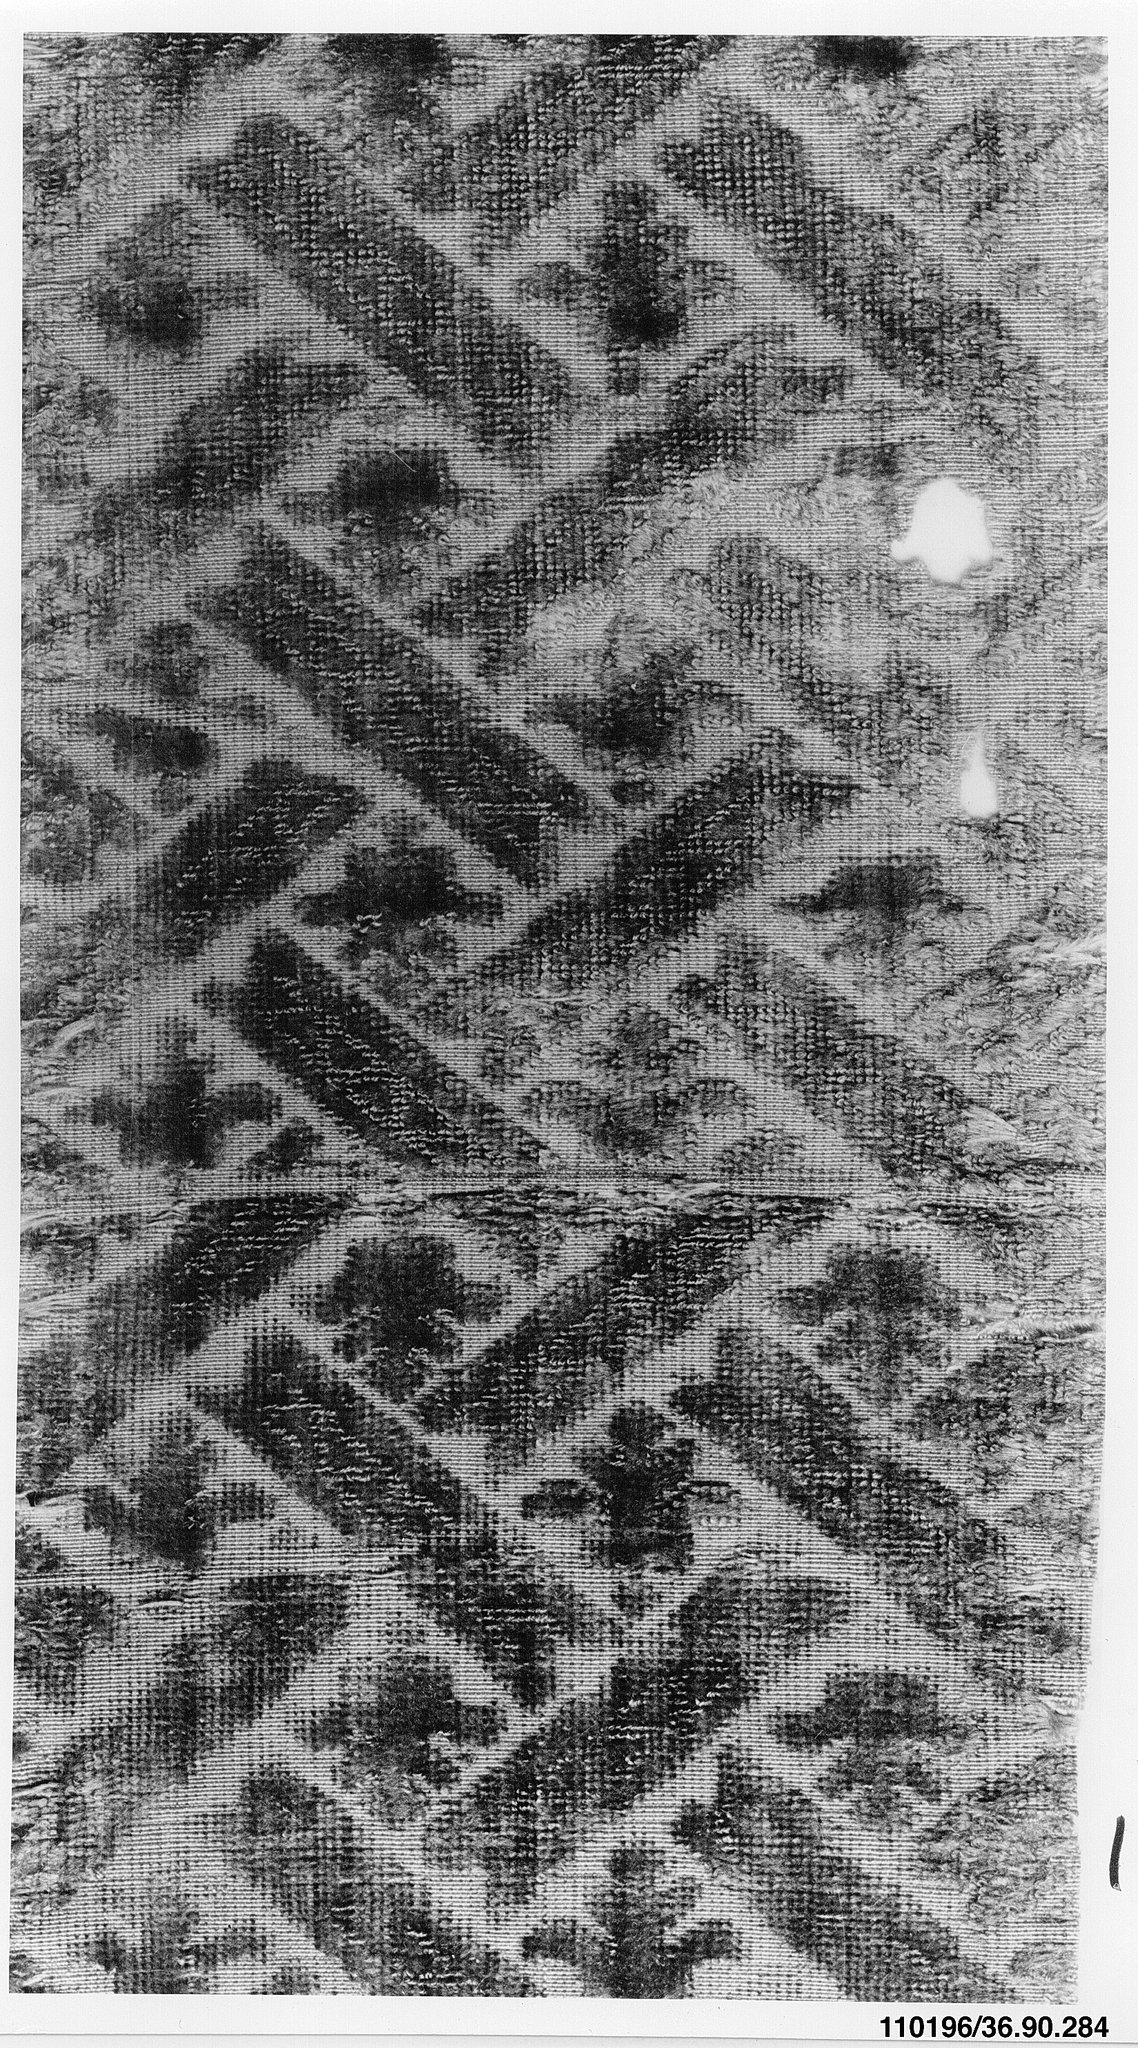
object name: piece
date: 1501-1700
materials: silk